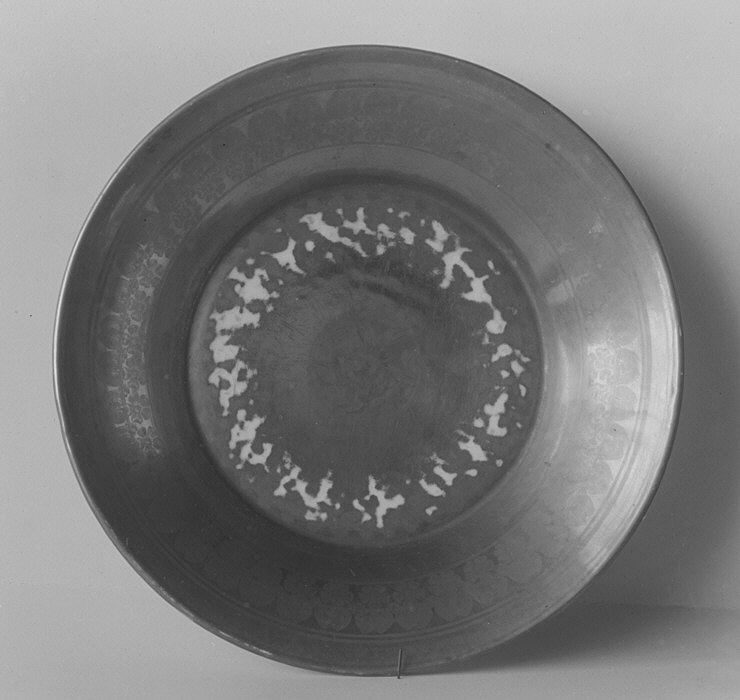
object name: saucer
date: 1815-1821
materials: hard paste porcelain